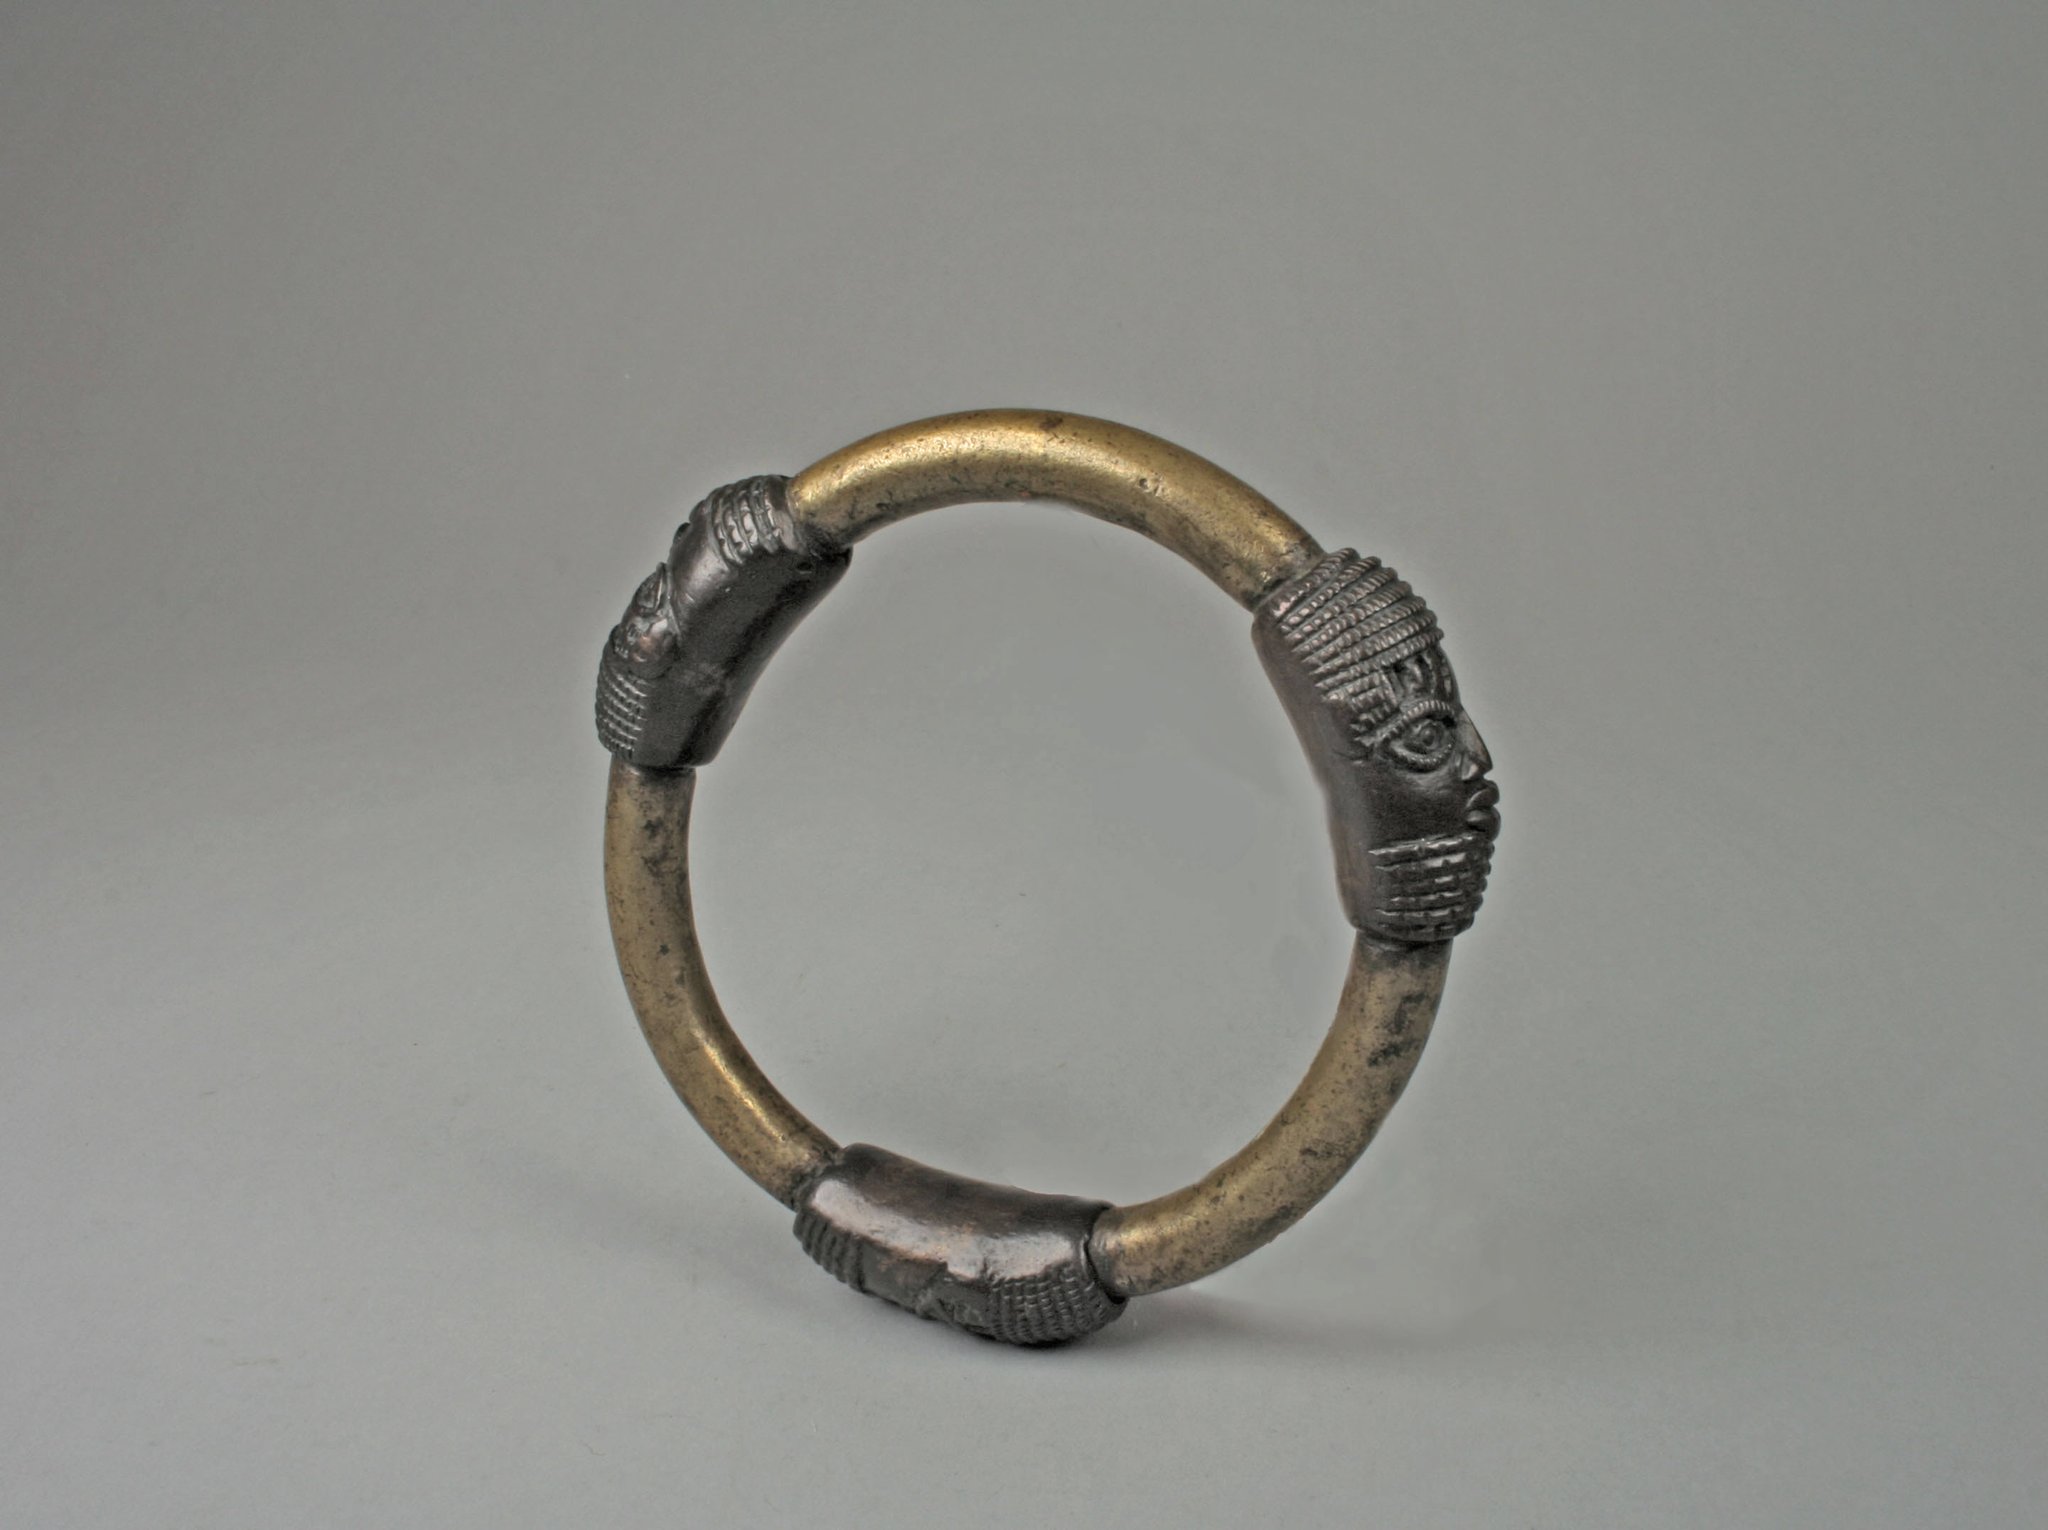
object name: bracelet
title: Bracelet: Three Heads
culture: edo period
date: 1701-1900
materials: brass, copper alloy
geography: nigeria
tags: heads